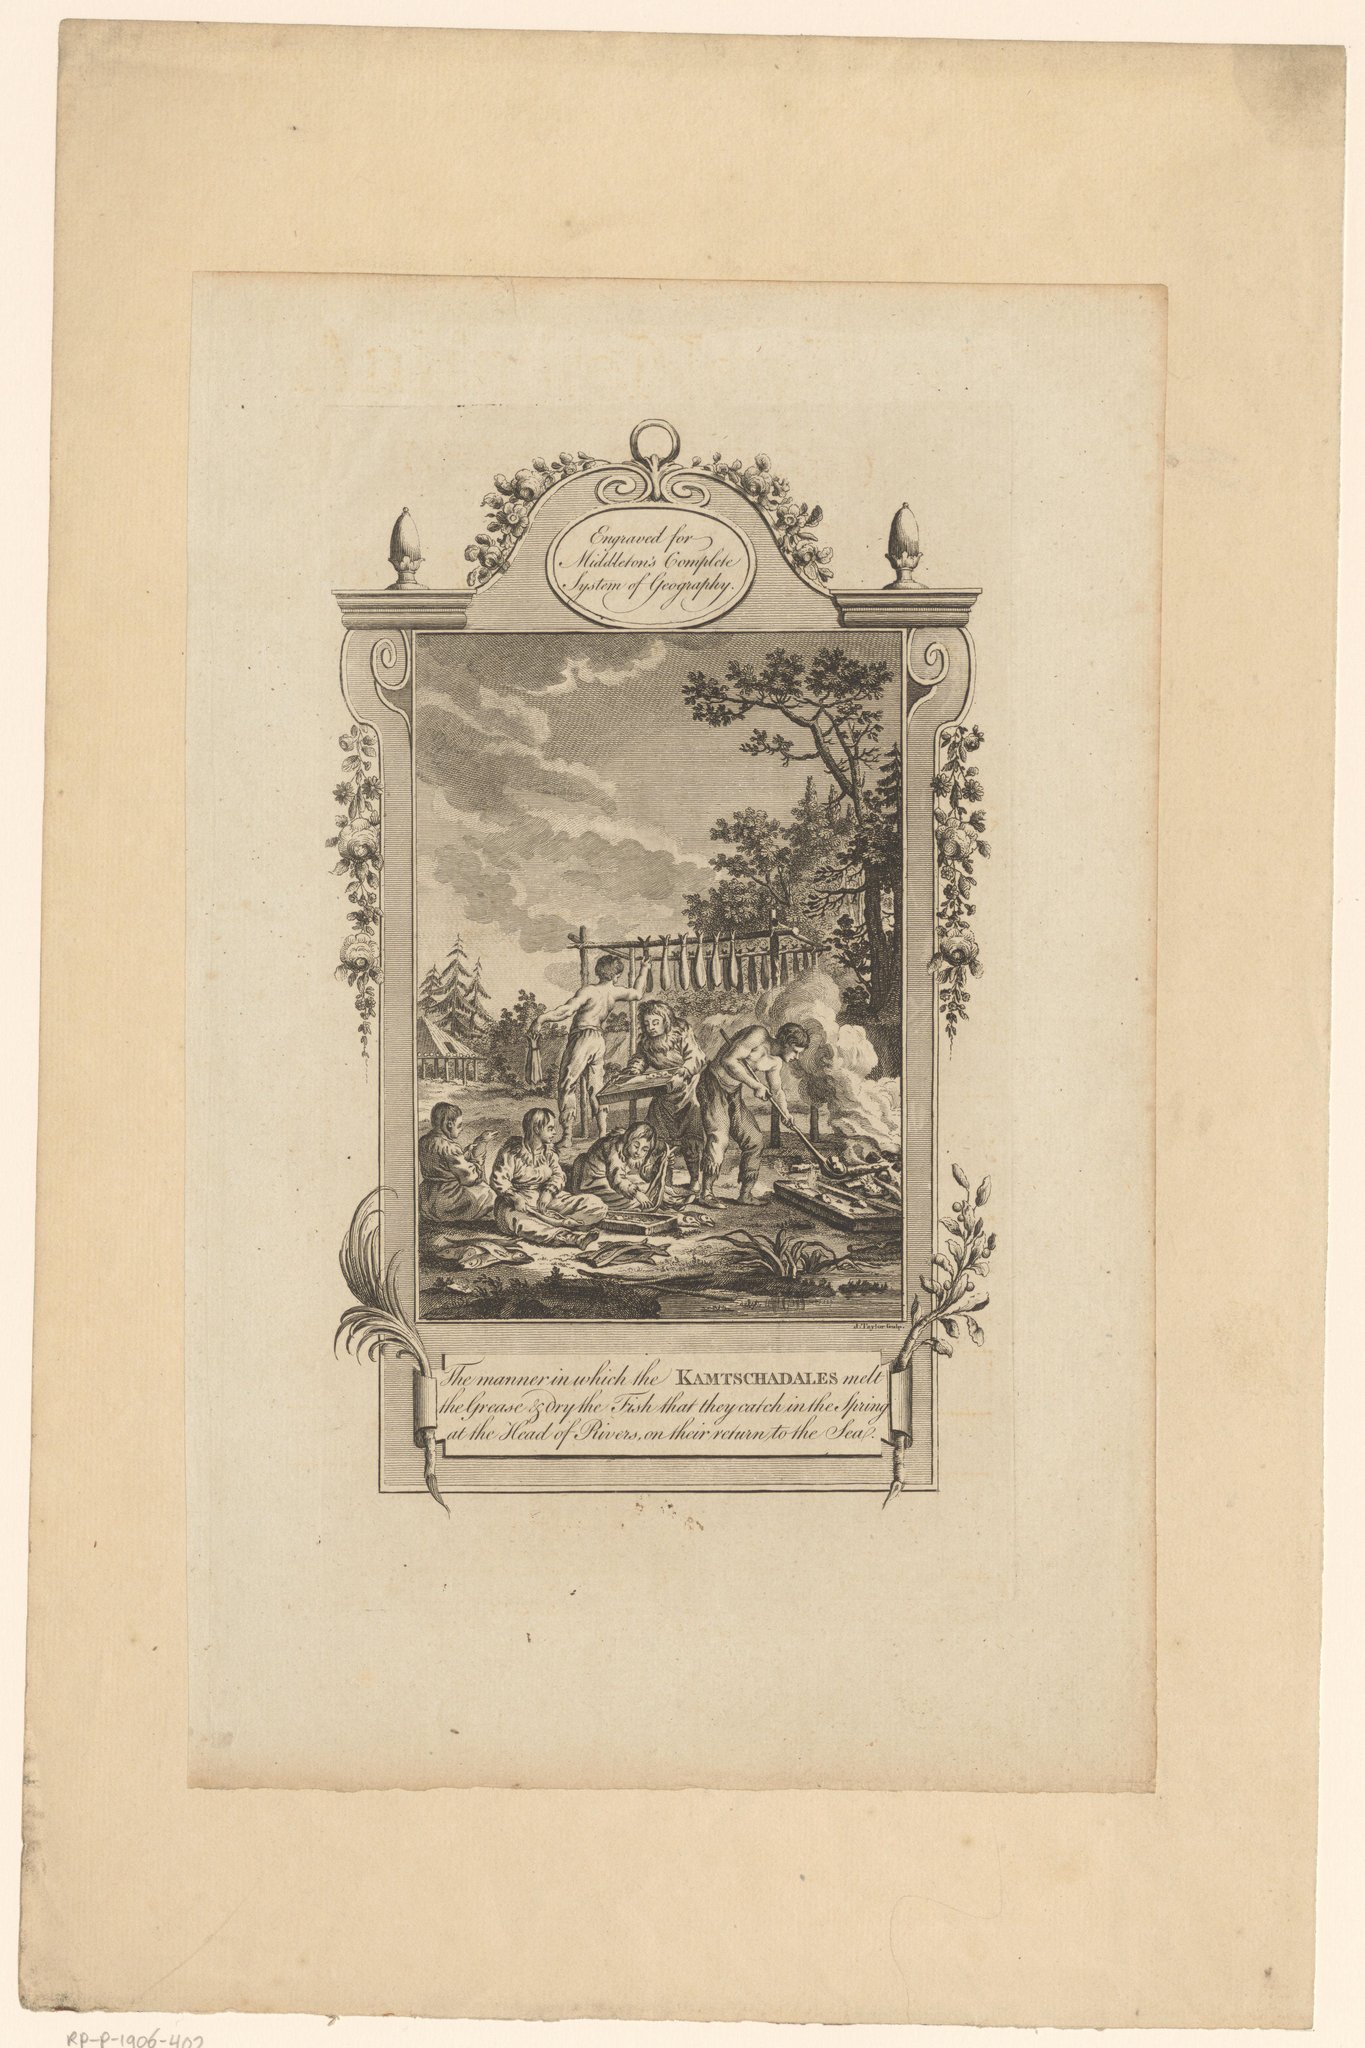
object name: print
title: The manner in which the Kamtschadales melt the Grease (...)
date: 1777-1780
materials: paper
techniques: etching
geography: london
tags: preparation of food - cc - in the open air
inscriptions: collector's mark: Lugt 2228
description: Prent uit: Middleton, Charles Theodore. A new and complete system of geography (...). Londen: John Cooke, [1777-1780], 2 dln.